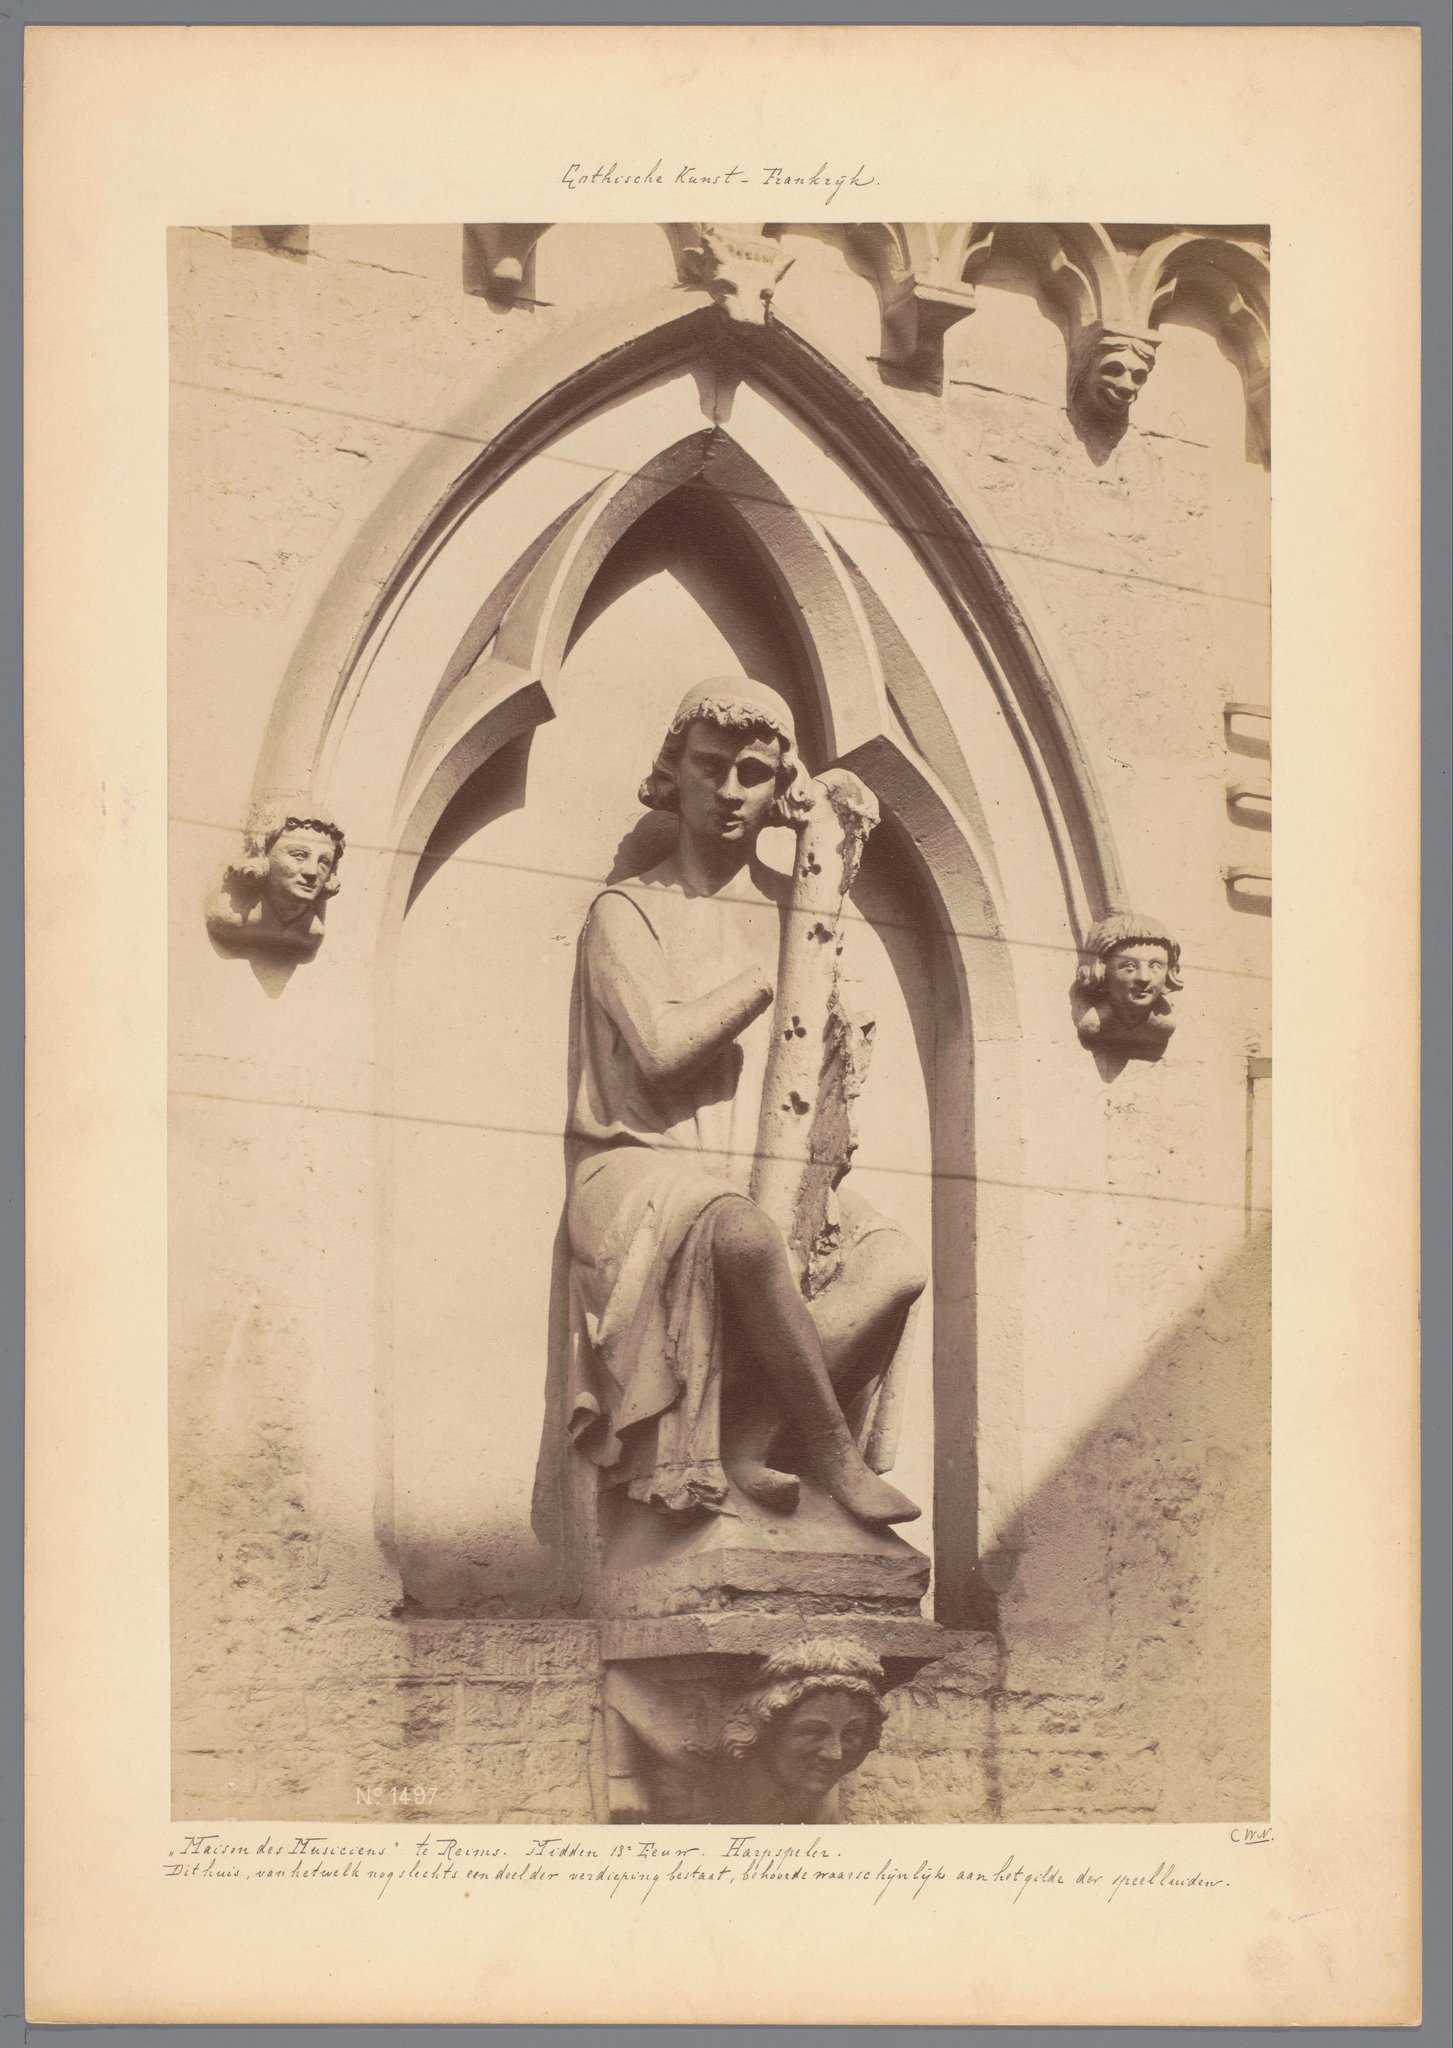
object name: photograph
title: Sculptuur van een harpspeler aan de gevel van Maison des musiciens te Reims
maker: séraphin-médéric mieusement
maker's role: fotograaf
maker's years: 1840-1905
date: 1875-1900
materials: cardboard, photographic support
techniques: albumen print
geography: reims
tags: harp, sculpture (+ relief ~ sculpture)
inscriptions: collector's mark: ‘KUNSTNIJVERHEIDSCHOOL QUELLINUS AMSTERDAM FRANS HALSSTRAAT 14.’, inscription: ‘MONUMENTS HISTORIQUES’, inscription: ‘CWN.’, collector's mark: ‘INSTITUUT VOOR KUNST-NIJVERHEIDSONDERWIJS GABRIËL METSUSTRAAT No. 16 AMSTERDAM’, name: ‘MIEUSEMENT PHOTOGRAPHE’, number: ‘No. 1497’, inscription: ‘Gothische Kunst - Frankrijk.’